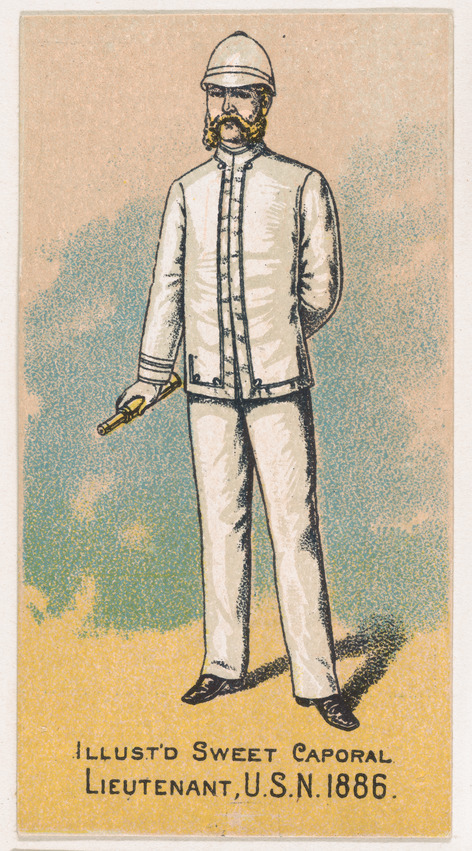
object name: print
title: Lieutenant, United States Navy, 1886, from the Military Series (N224) issued by Kinney Tobacco Company to promote Sweet Caporal Cigarettes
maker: kinney brothers tobacco company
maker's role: publisher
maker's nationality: american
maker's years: 1869-2011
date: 1888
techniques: color lithograph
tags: soldiers,men